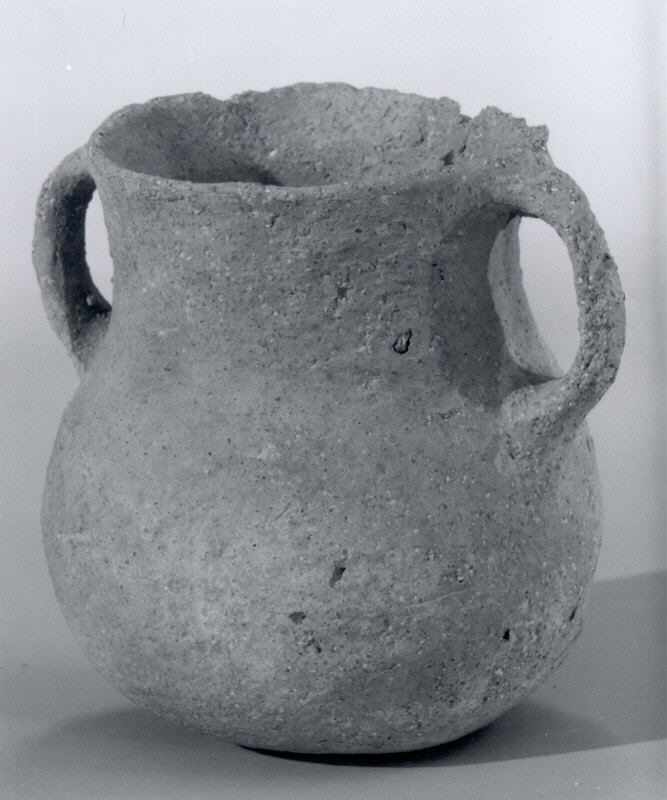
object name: jar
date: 3500-3300 BCE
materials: ceramic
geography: levant